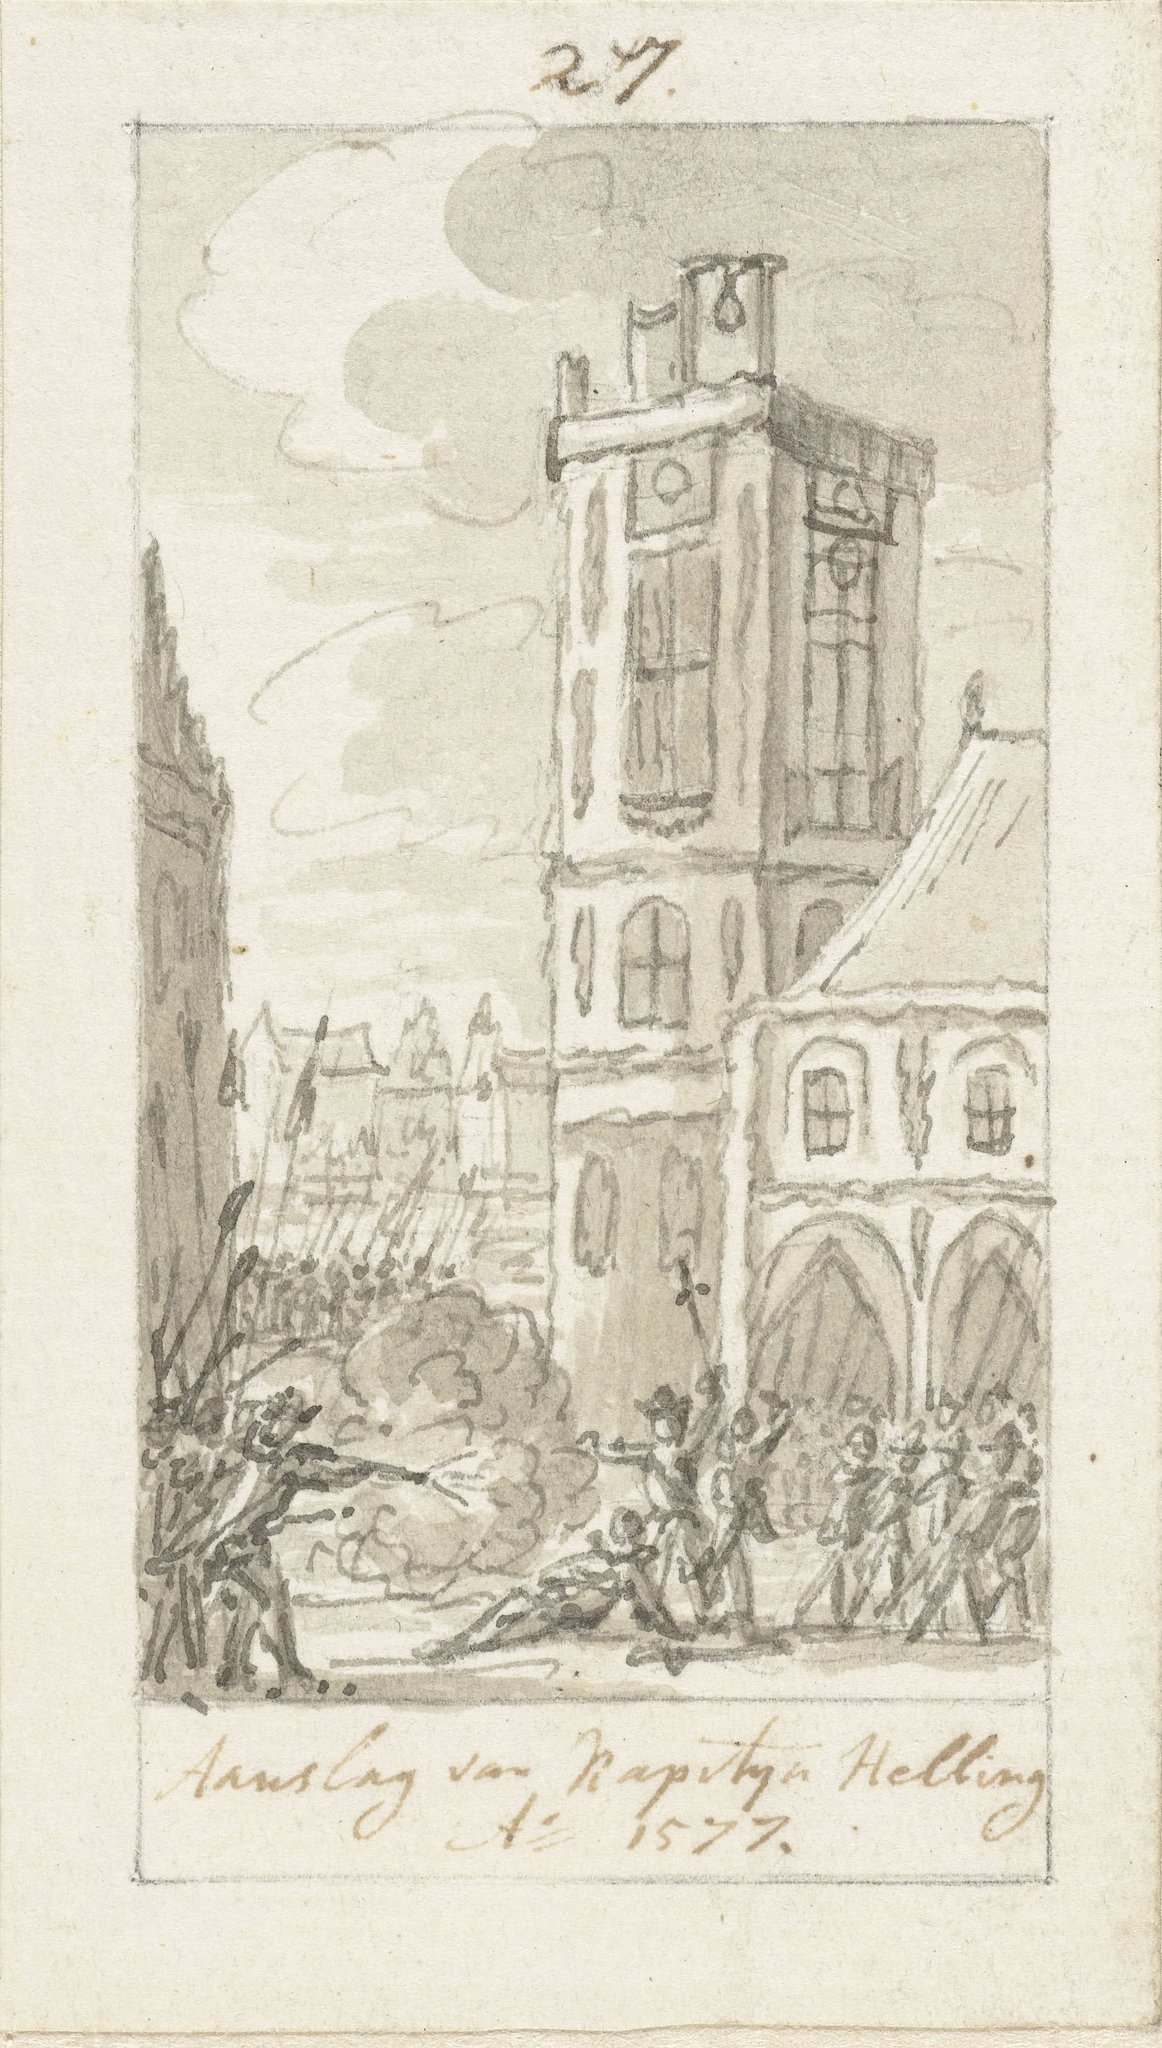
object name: design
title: Het sneuvelen van Kapitein Herman van der Helling, 23 november 1577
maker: simon fokke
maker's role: draughtsman, print maker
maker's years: 1712-1784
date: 1722-1784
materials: ink, paper, pencil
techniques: brush, pen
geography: netherlands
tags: haarlem, (revolutionary) plot, conspiracy, historical persons, violent death, being killed; being mishandled and maltreated; seeking death, historical events and situations, amsterdam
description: Aanslag van Helling en Ruychaver op Amsterdam, 23 november 1577. Gevechten op de Dam voor het stadhuis waarbij Gelling sneuvelt. Ontwerp voor een prent.